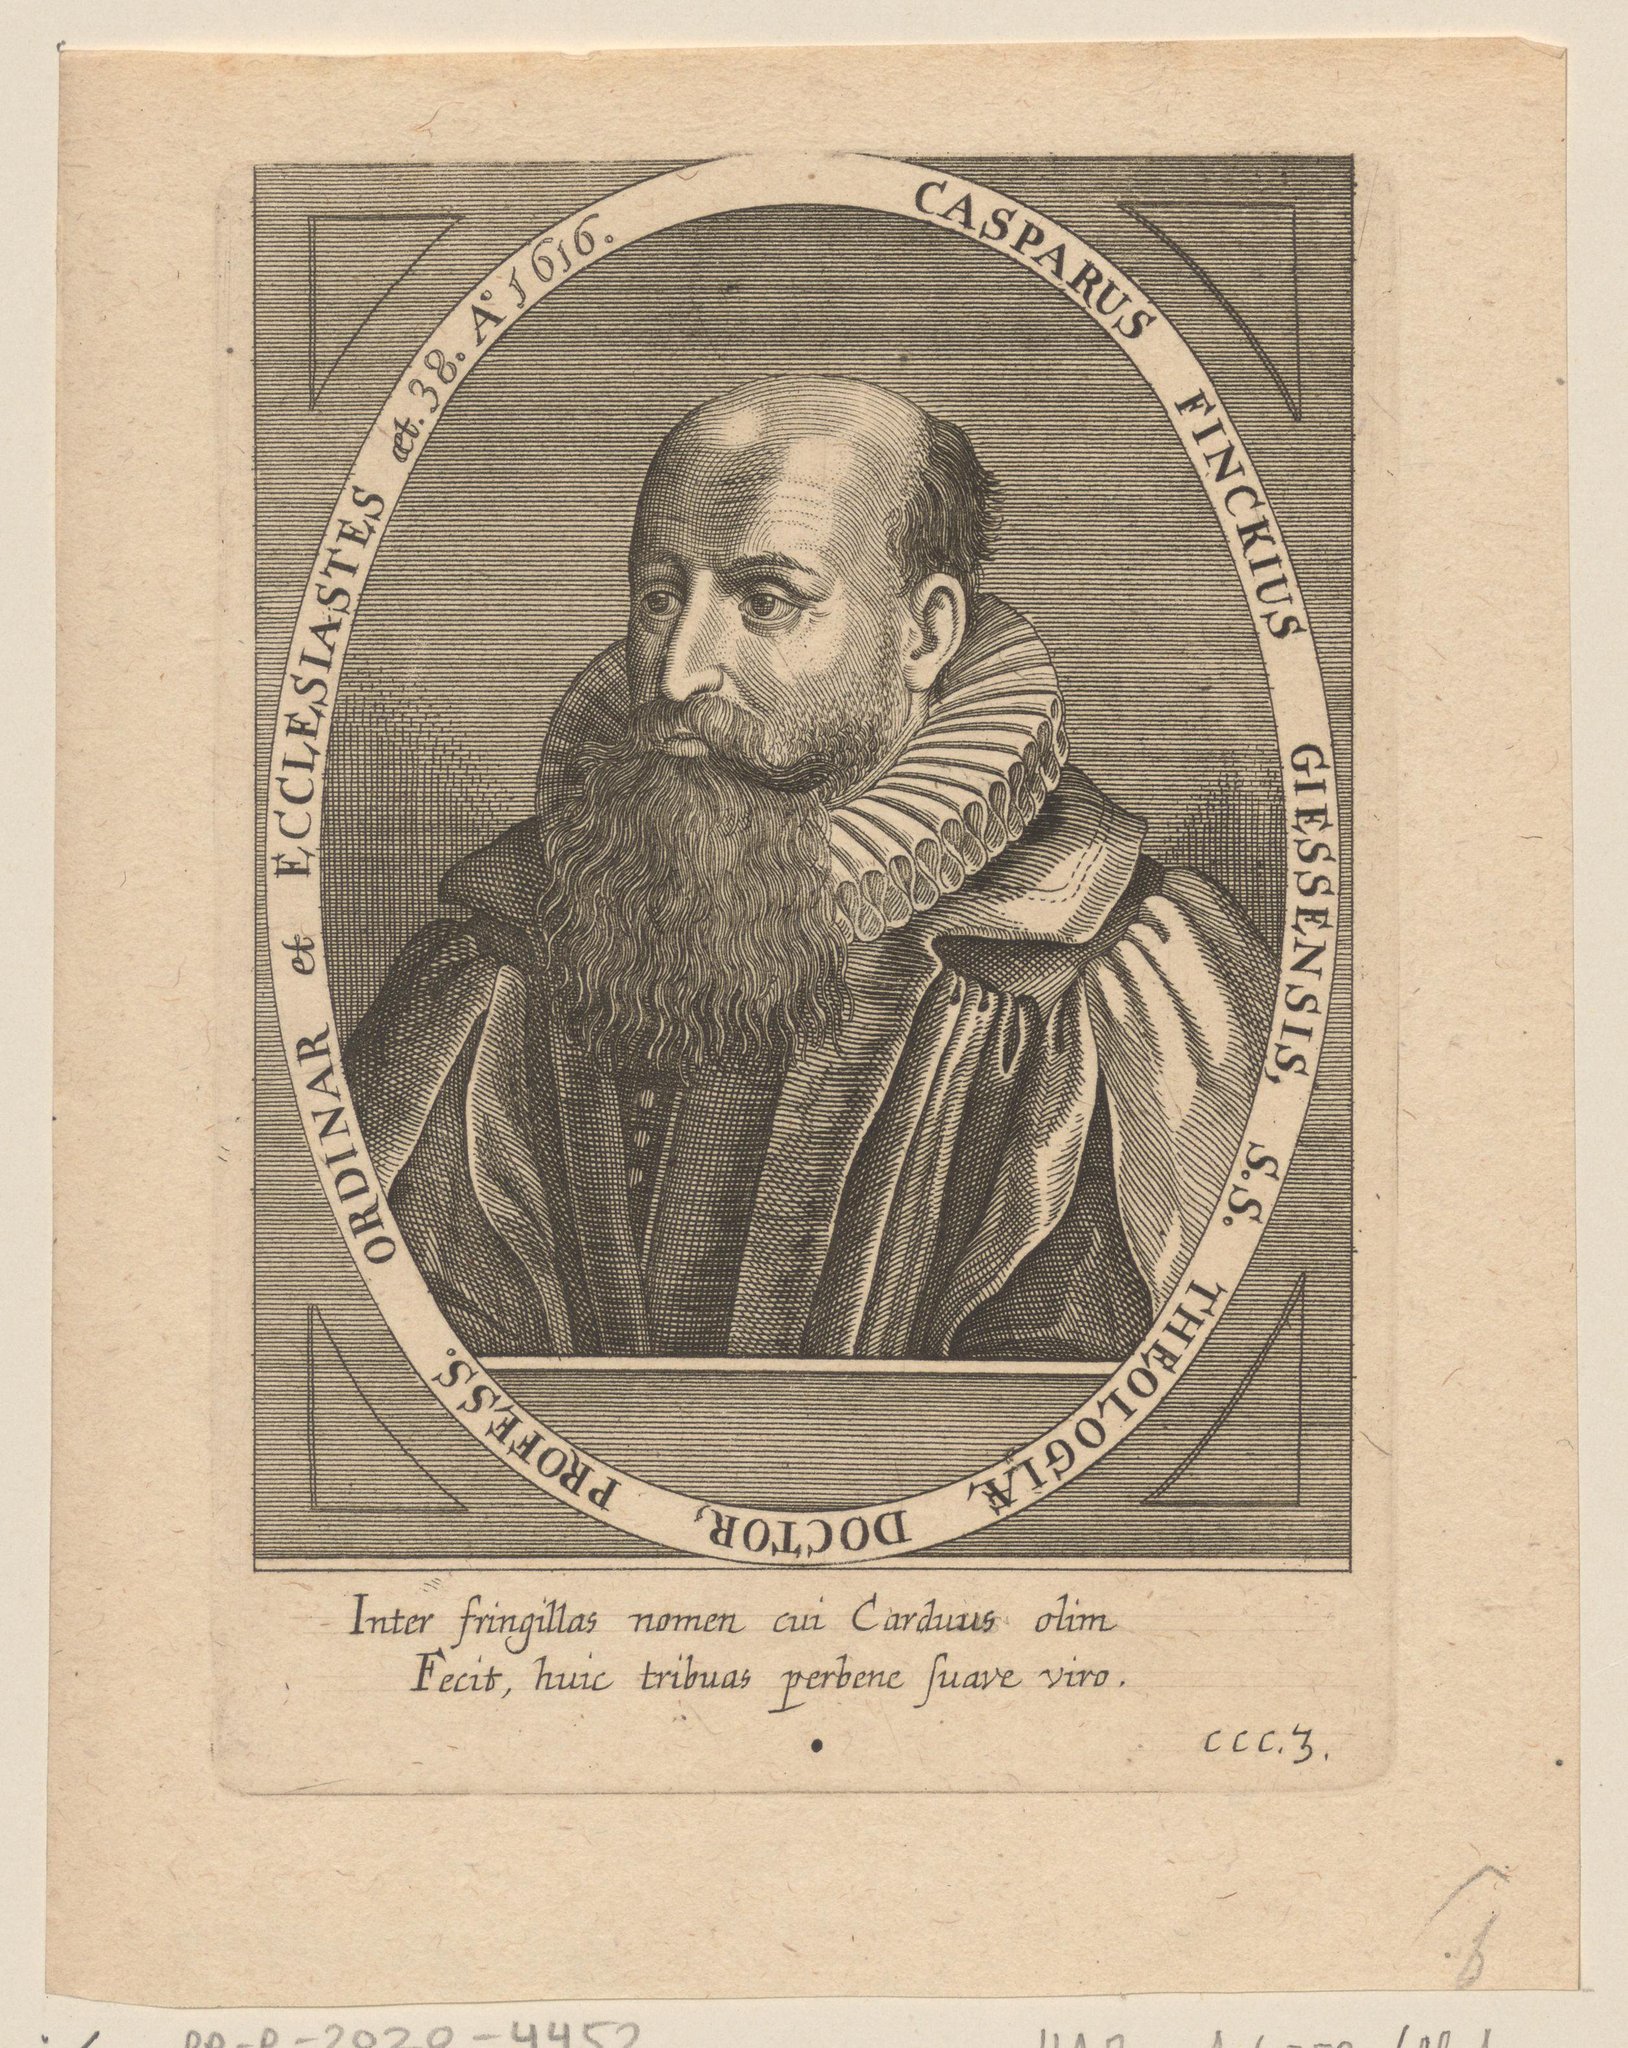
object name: print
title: Portretten van geleerden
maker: clemens ammon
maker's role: print maker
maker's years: 1627-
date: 1652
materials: paper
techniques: engraving, etching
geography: germany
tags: historical persons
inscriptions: collector's mark: Lugt 2233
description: Prent waarschijnlijk uit: Boissard, Jean Jacques. Bibliotheca chalcographica (...) VIII Pars. Frankfurt am Main: Johannes Ammon, 1652.